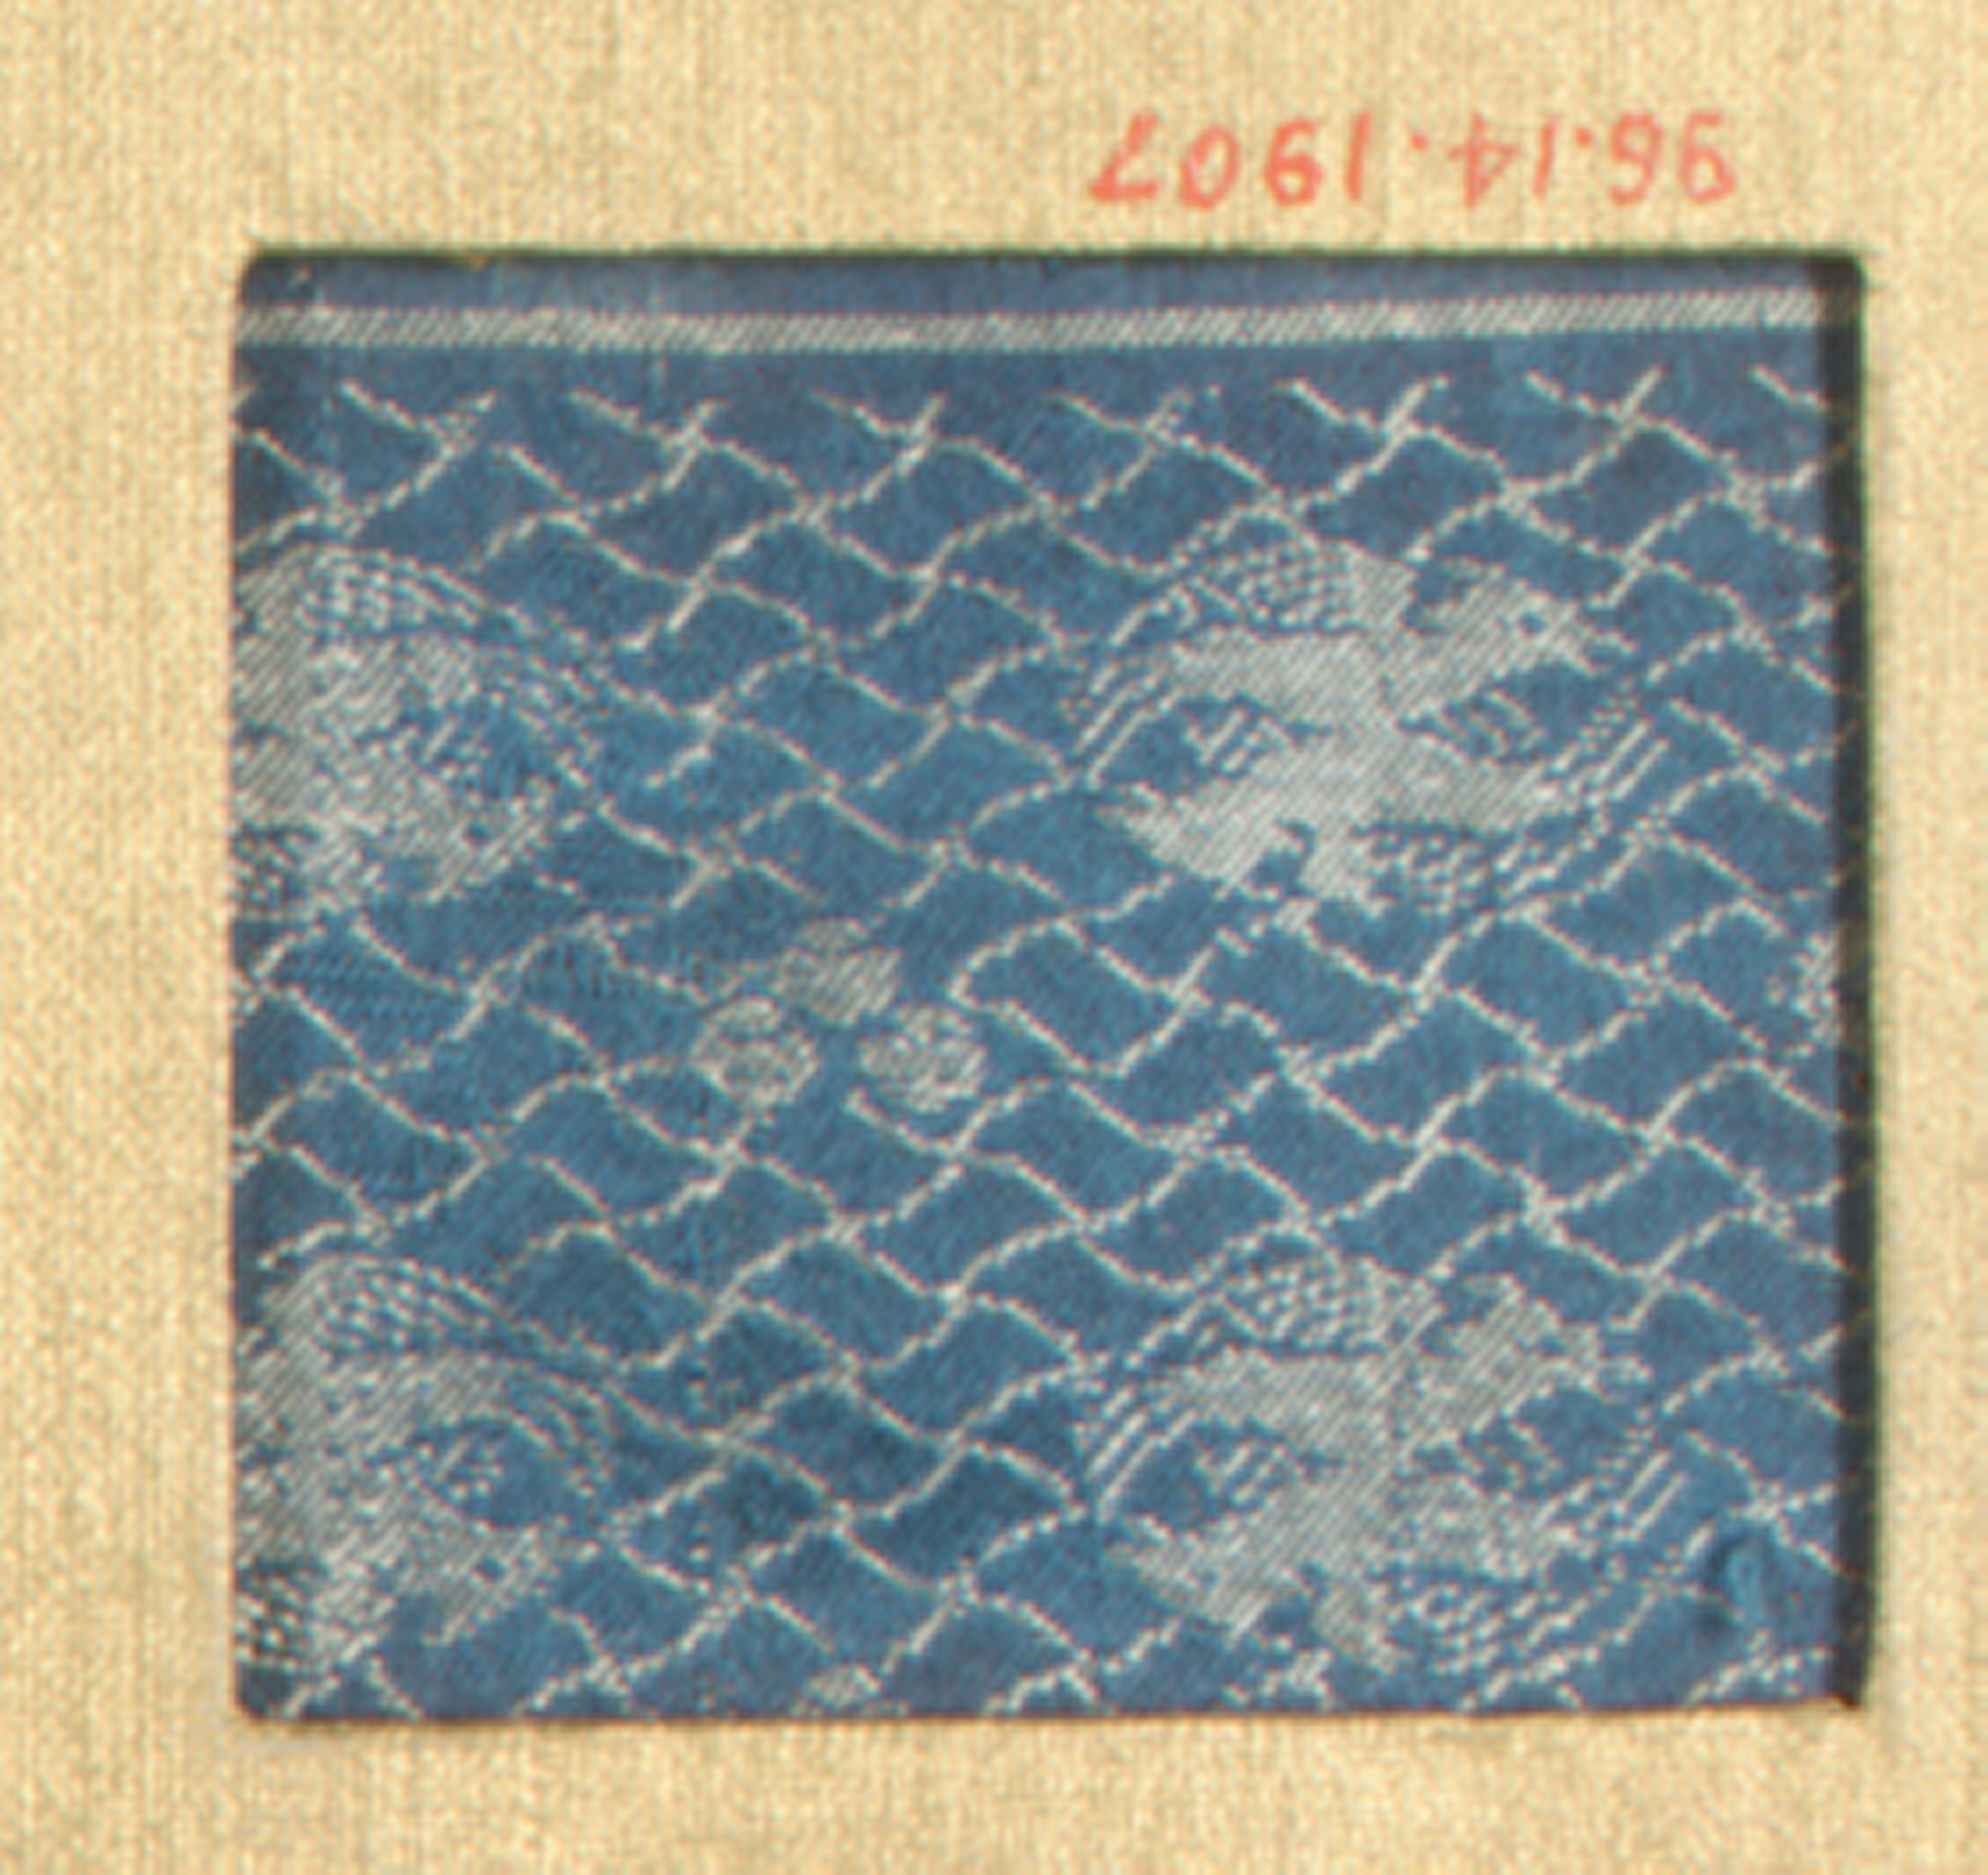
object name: piece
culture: japanese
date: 1701-1900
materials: silk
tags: birds